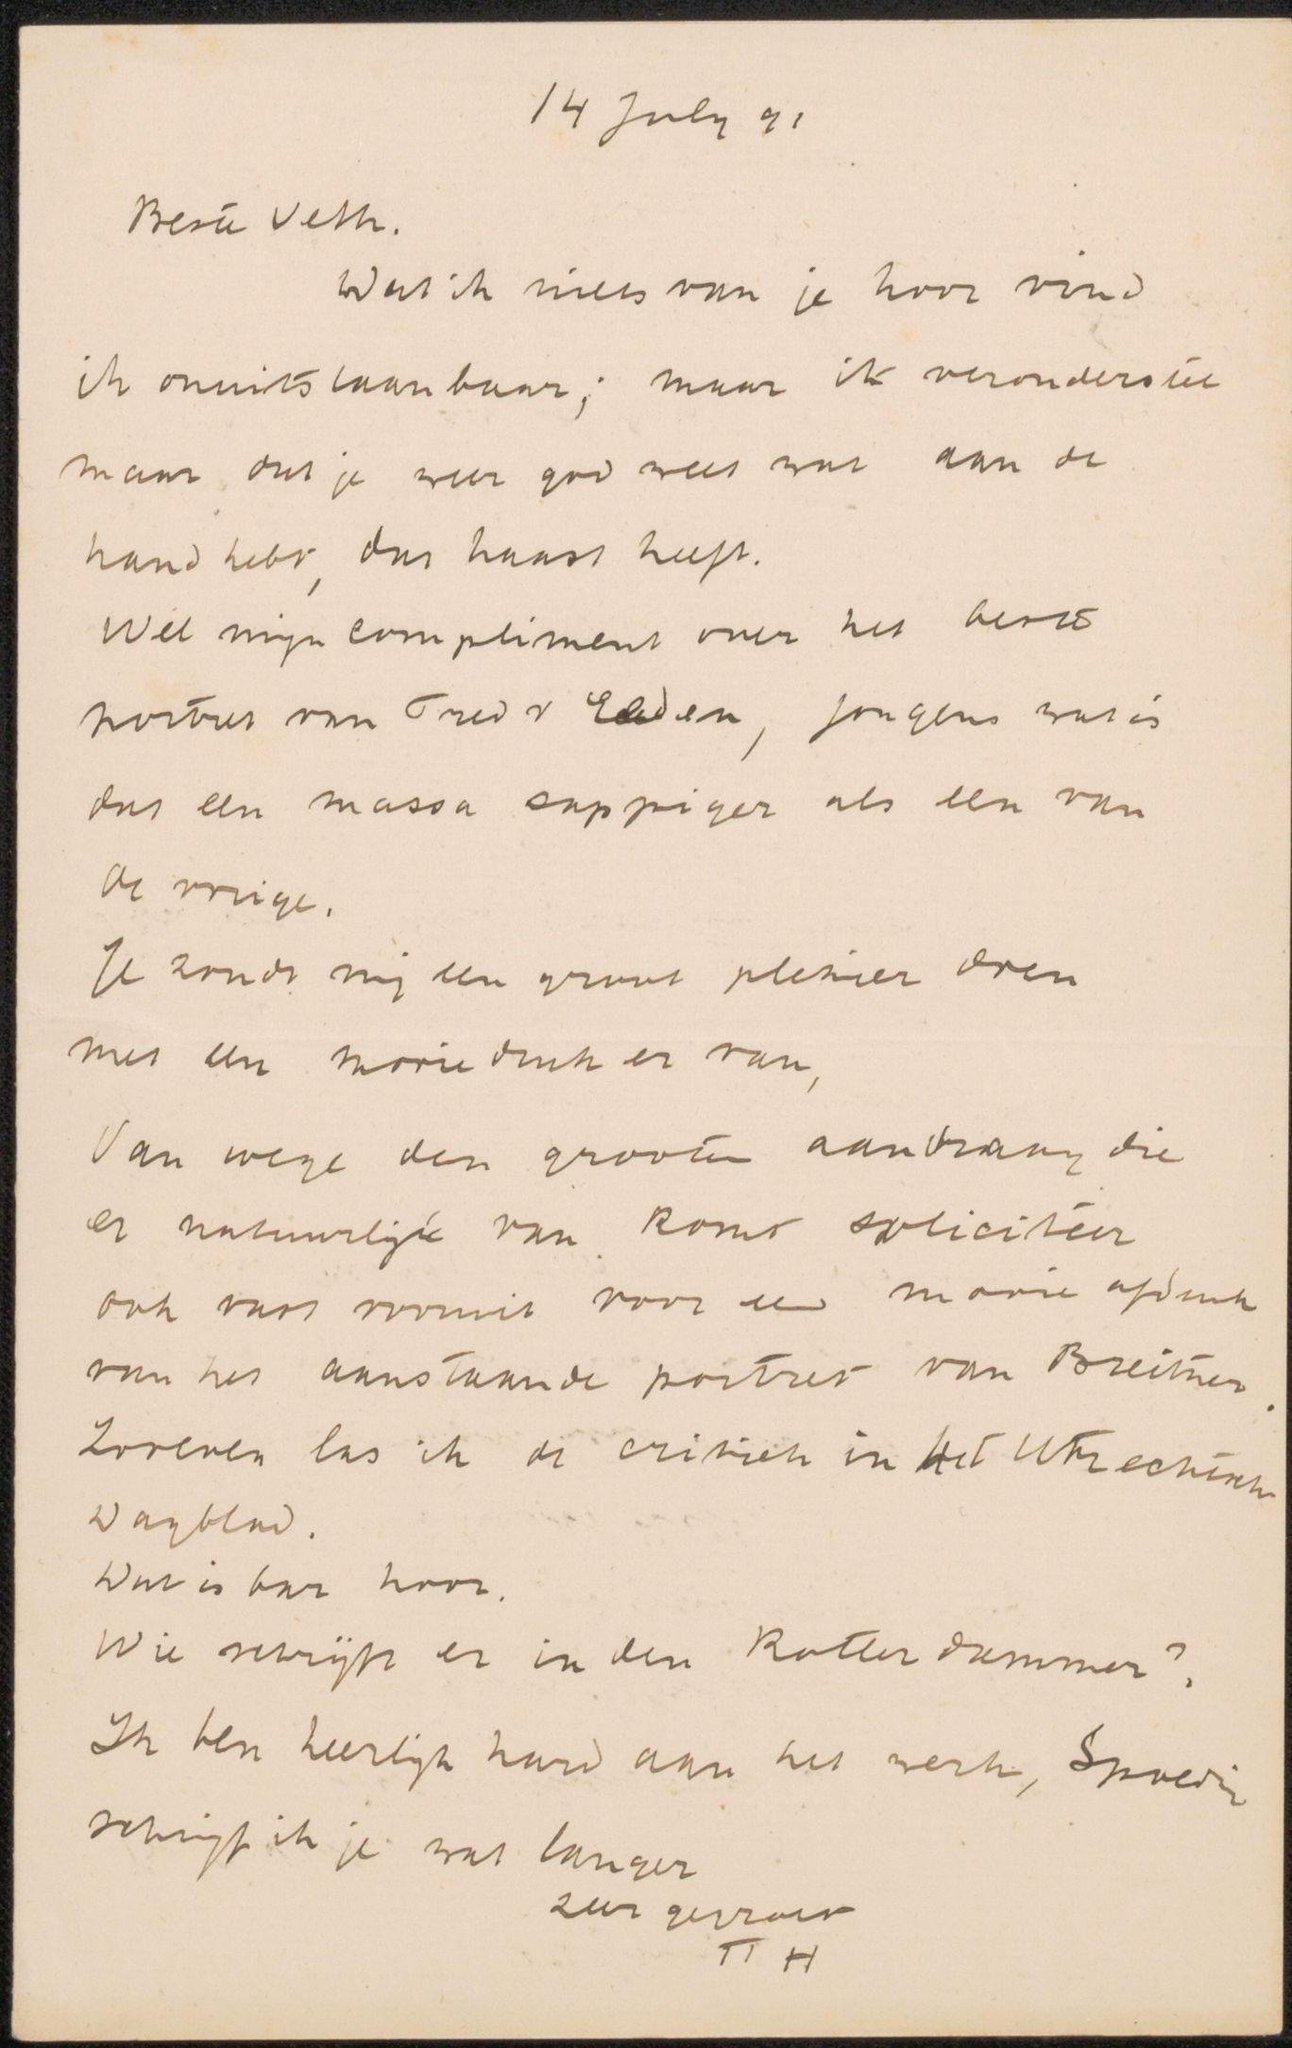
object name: letter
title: Brief aan Jan Veth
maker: richard nicolaüs roland holst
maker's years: 1868-1938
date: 1891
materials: ink, paper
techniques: pen, writing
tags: rotterdam, amsterdam, painter, print maker, draughtsman, george hendrik breitner, designer, jan veth, publisher, haarlem, frederik van eeden, criticizing and discussing art, art criticism, historical persons (portraits and scenes from the life)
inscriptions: collector's mark: ‘RPK’